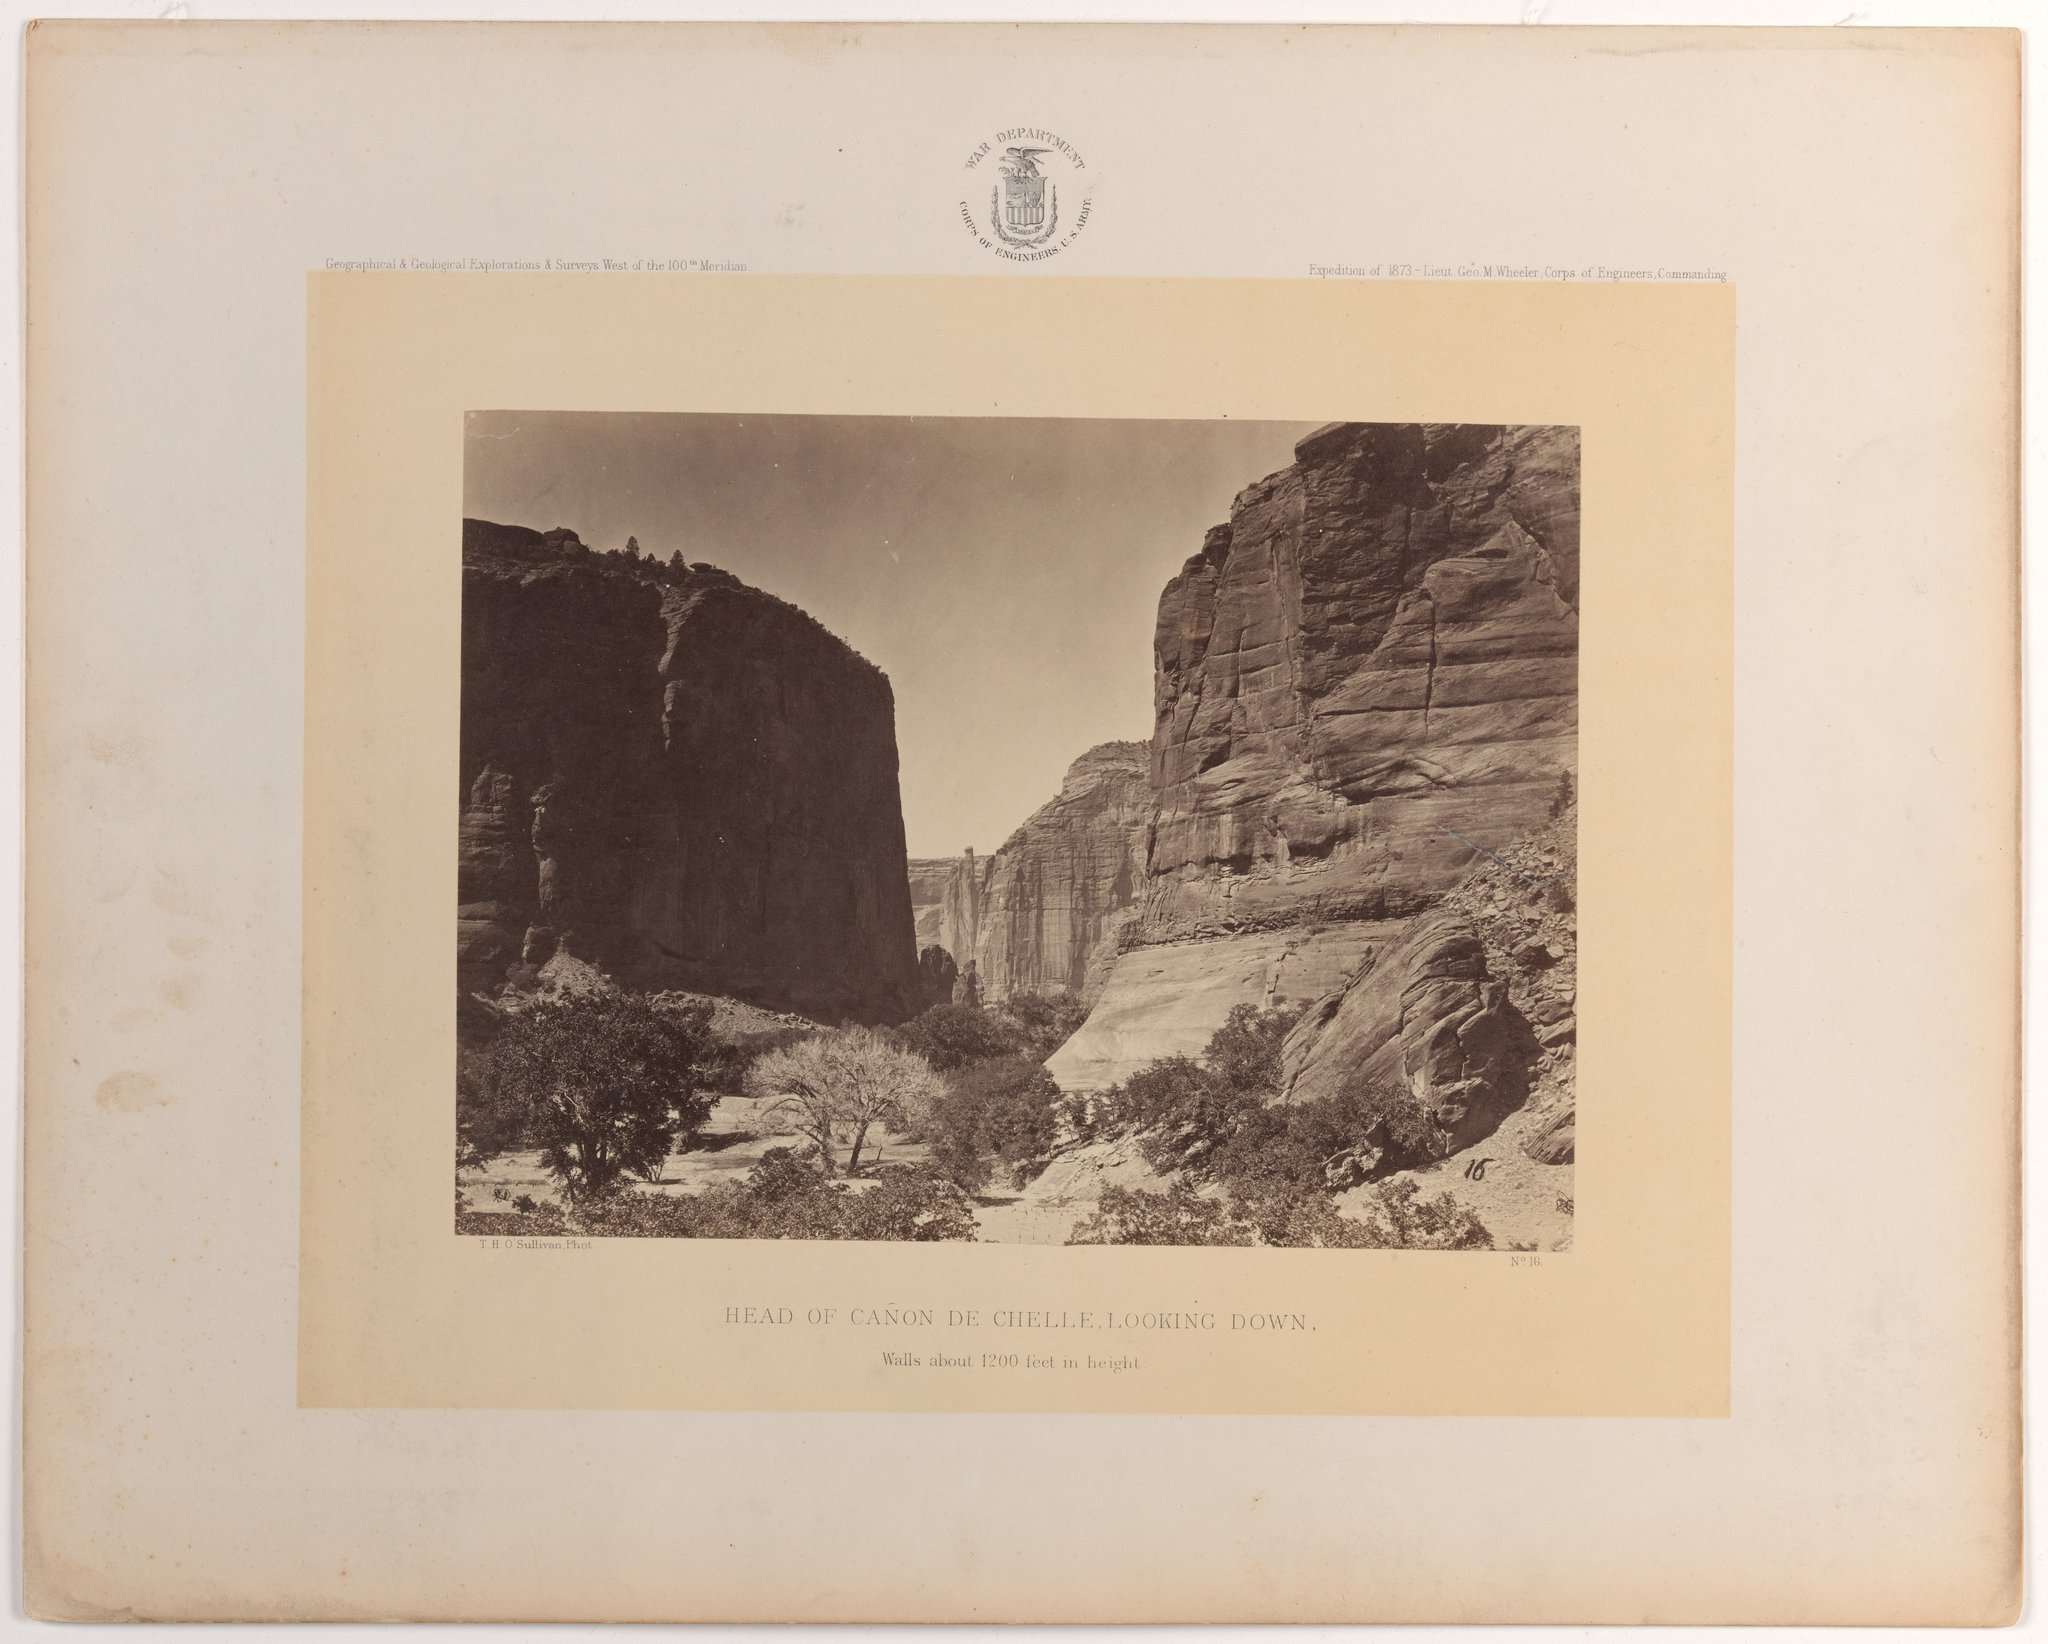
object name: photograph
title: Head of Cañyon de Chelle, Looking Down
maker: timothy h. o'sullivan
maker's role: artist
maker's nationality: american, born ireland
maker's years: 1840-1882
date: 1873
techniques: albumen silver print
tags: landscapes